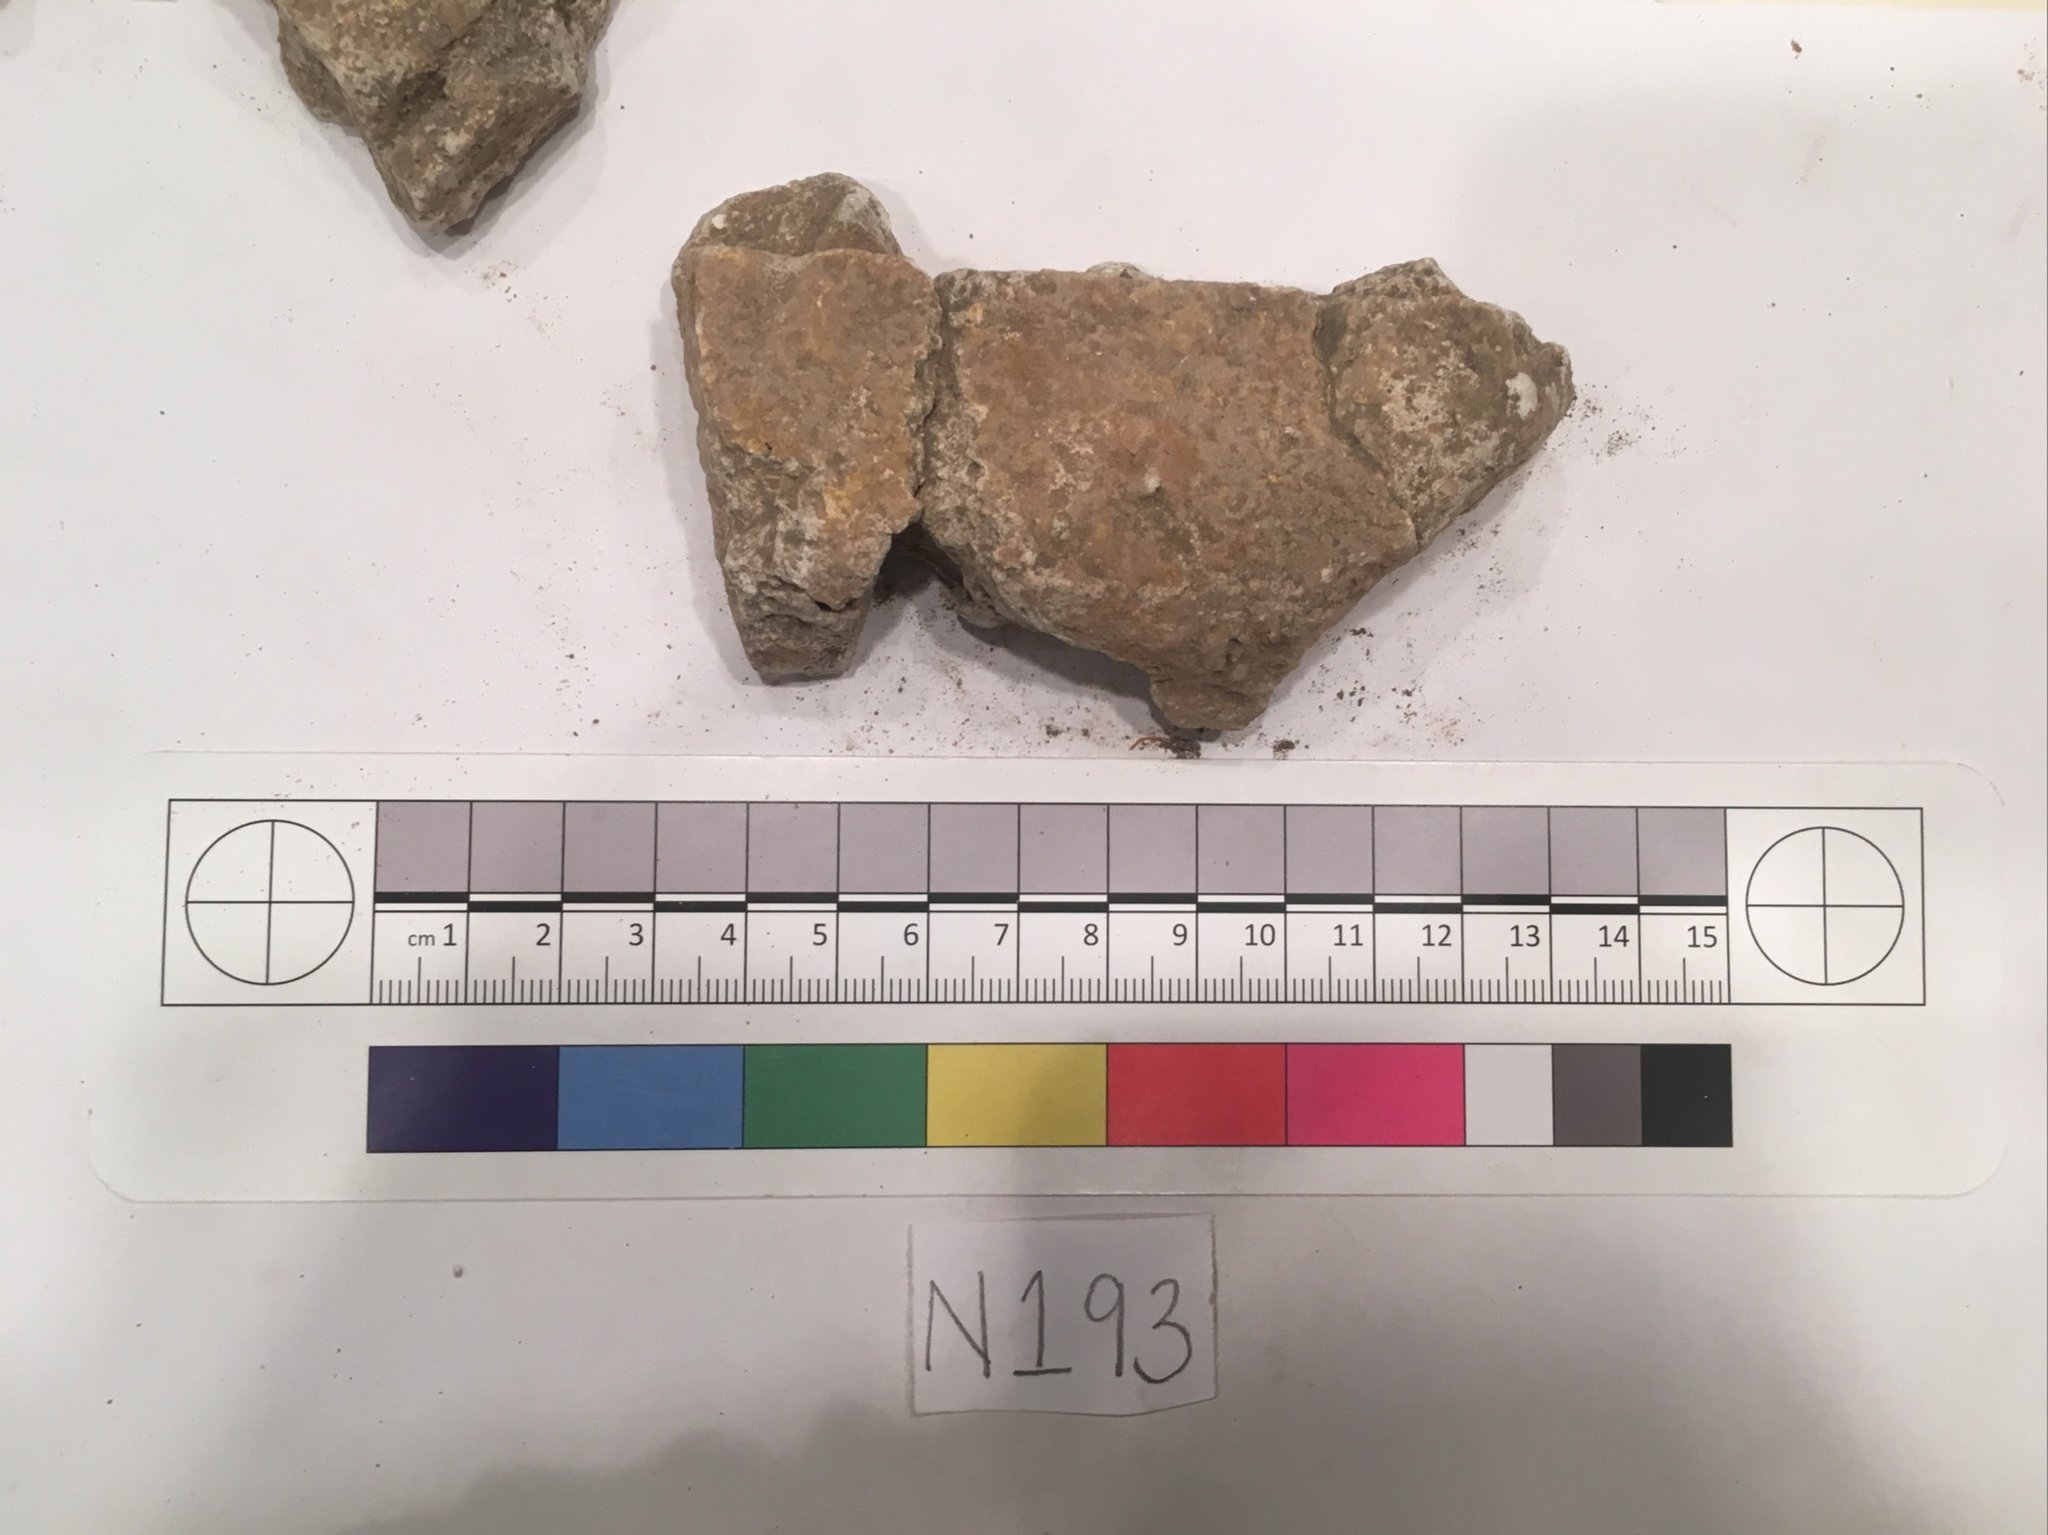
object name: fragment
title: Stucco Fragment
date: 701-1200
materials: plaster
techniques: carving, painting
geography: iran